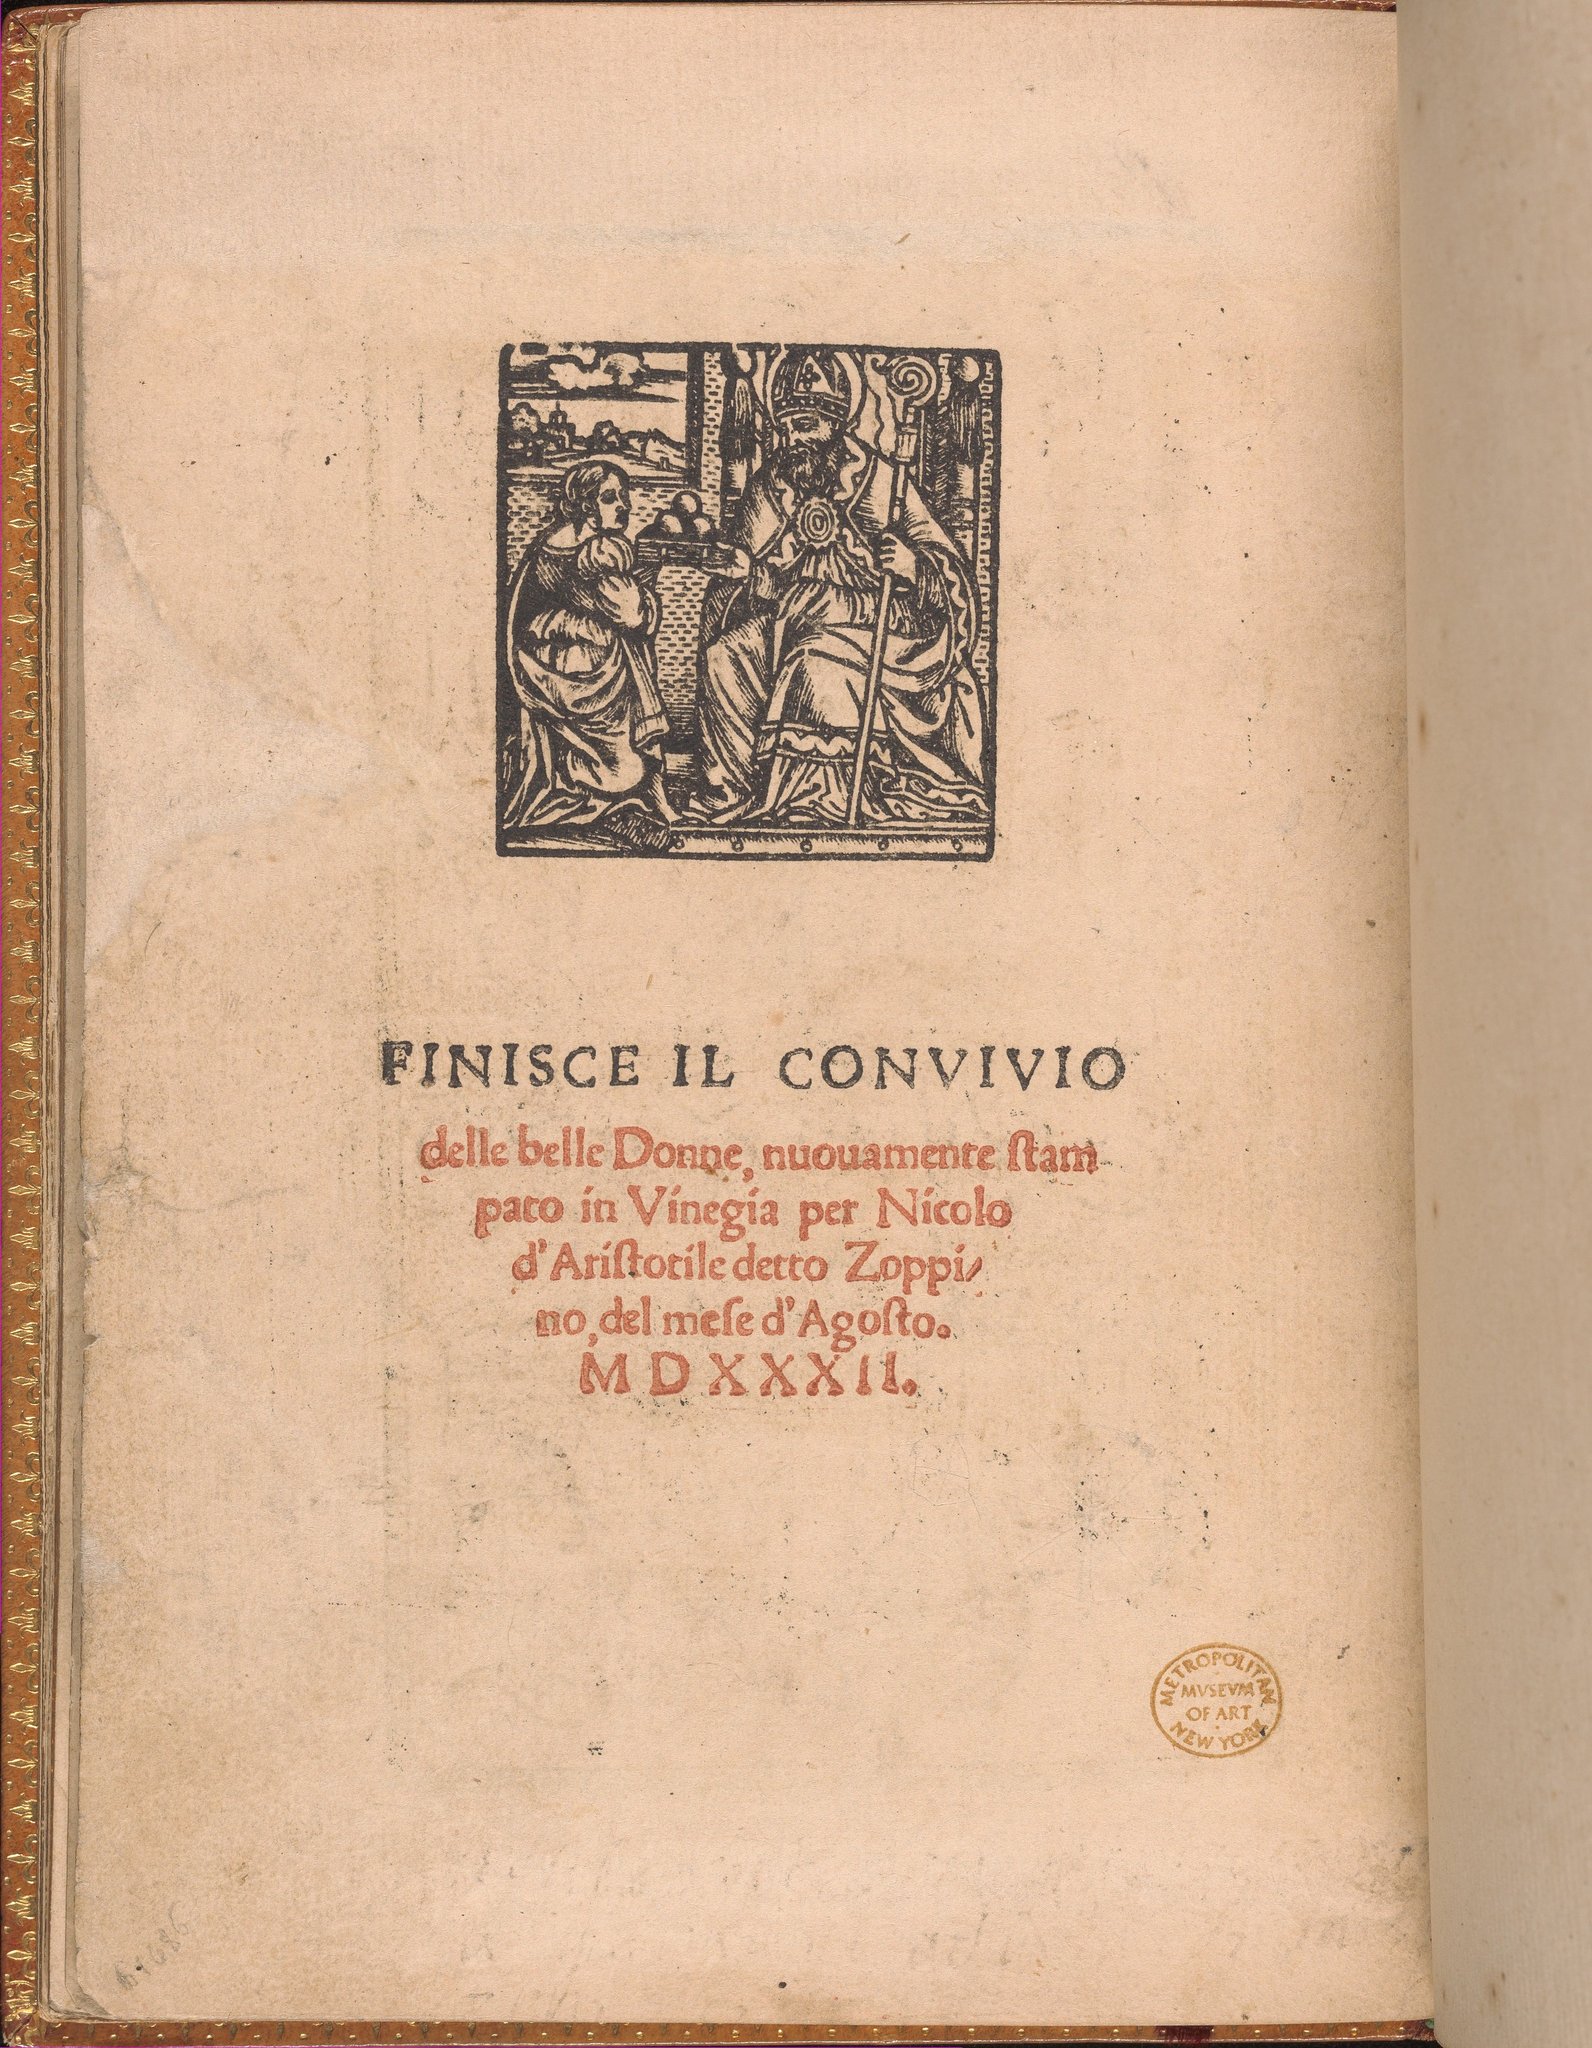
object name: book print ornament architecture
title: Convivio delle Belle Donne, page 22 (verso)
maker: nicolò zoppino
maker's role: publisher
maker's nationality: italian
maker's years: 1478-1544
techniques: woodcut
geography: italy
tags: men,women